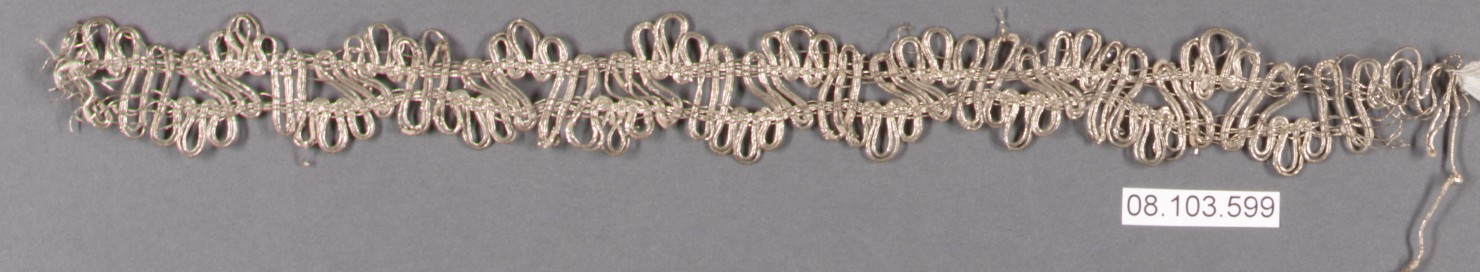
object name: galloon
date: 1701-1800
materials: metal thread